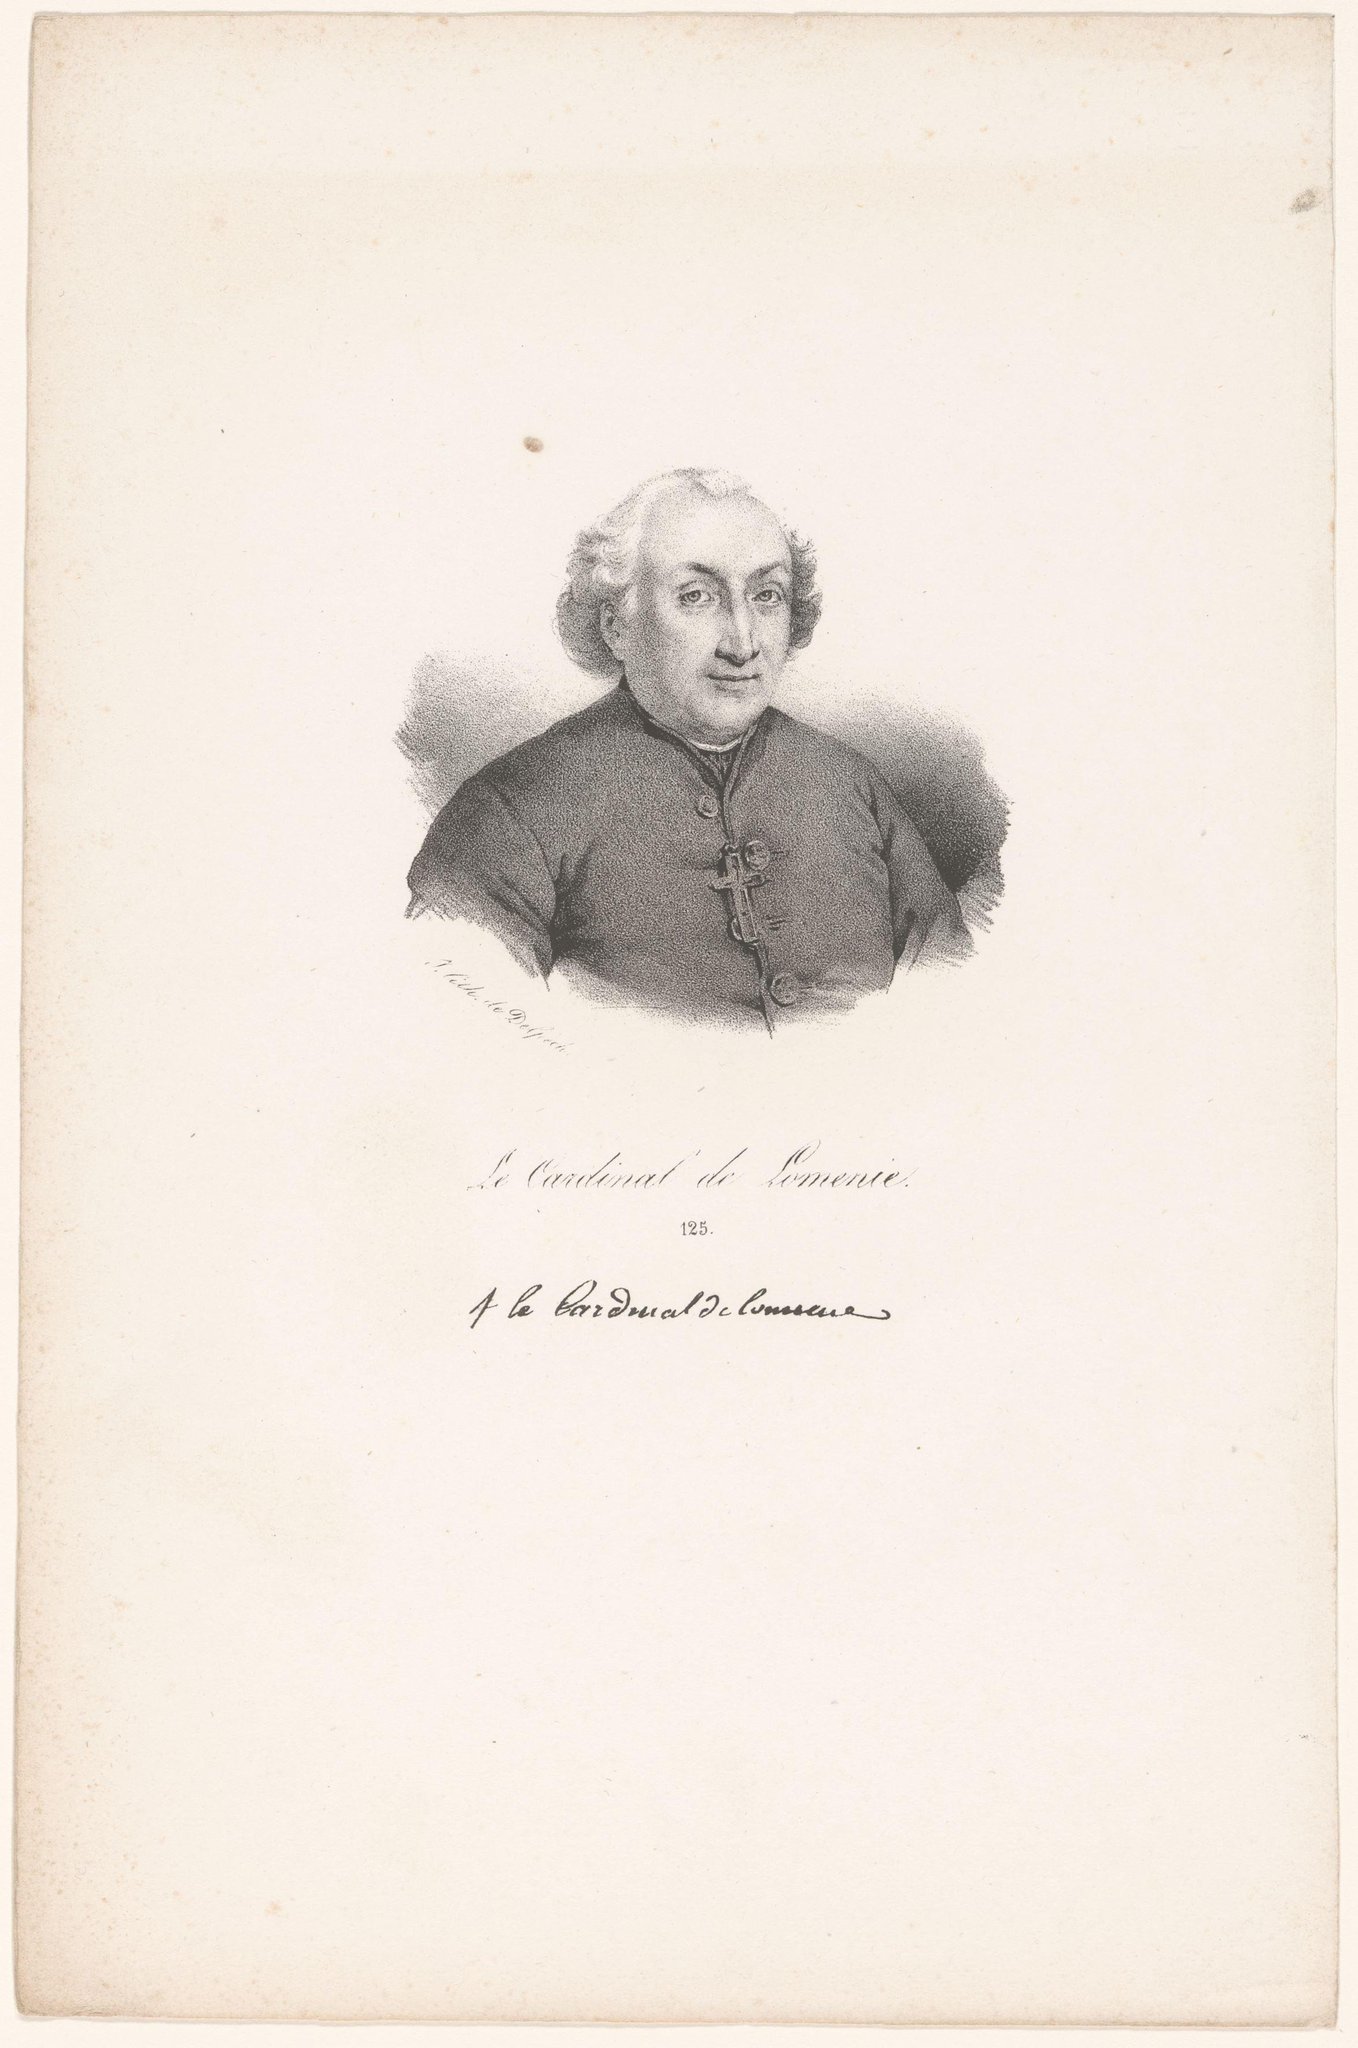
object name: print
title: Le Cardinal de Lomenie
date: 1818-1842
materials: paper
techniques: lithograph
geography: paris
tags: paris, politician, historical persons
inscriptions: collector's mark: Lugt 2228a